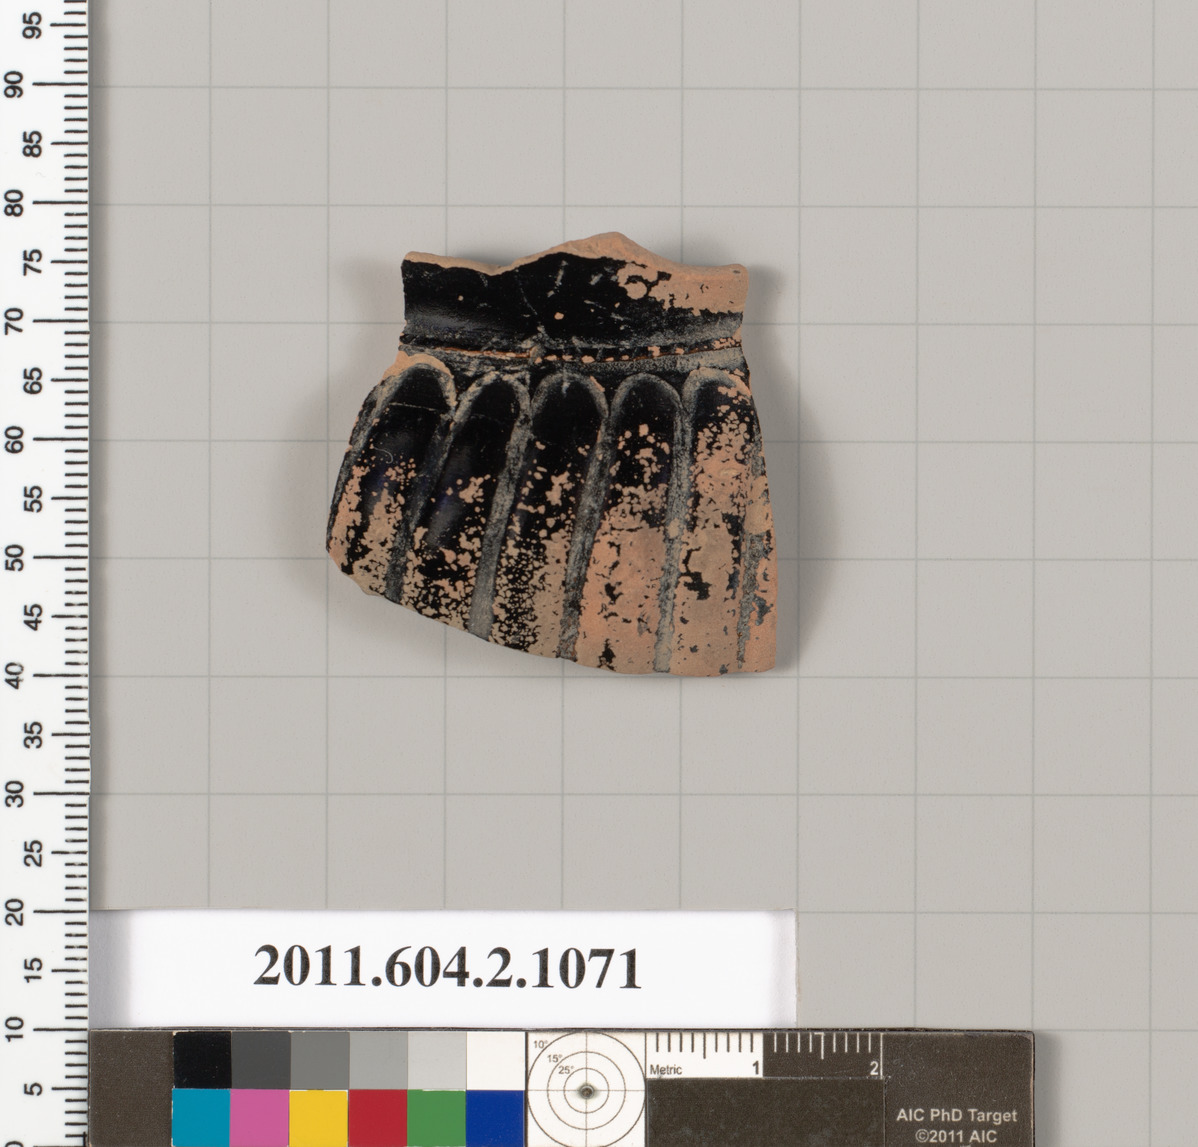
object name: mug, oinochoe, shape 8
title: Terracotta fragments of a mug, oinochoe, shape 8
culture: greek, attic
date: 425-401 BCE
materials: terracotta